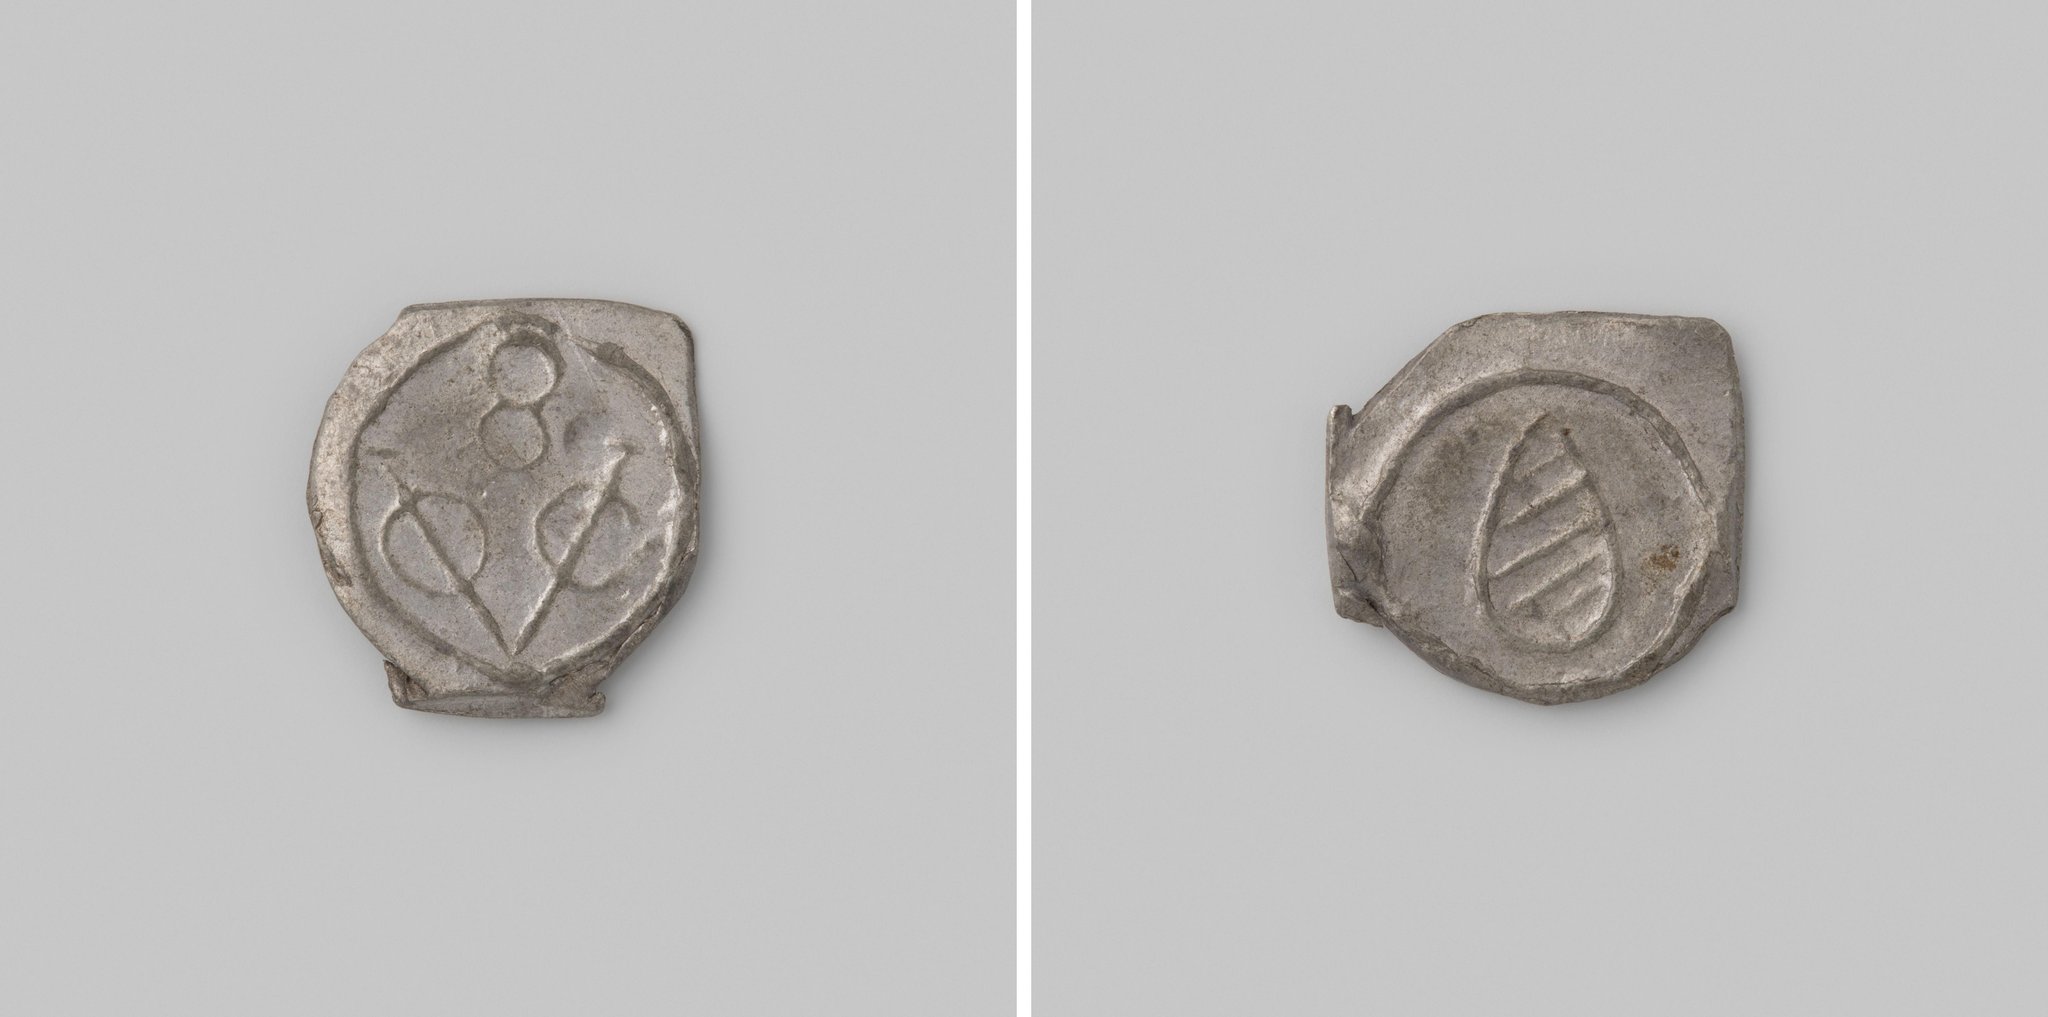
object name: bazaroek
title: Tinnen bazaroek uit Cochin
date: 1724-1795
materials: tin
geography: kochi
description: Hoekig geknipte, min of meer, ronde munt. Voorzijde: binnen cirkel VOC-beeldmerk met 8 erboven. Keerzijde: binnen cirkel, peervormig schild met 4 schuine streepjes.